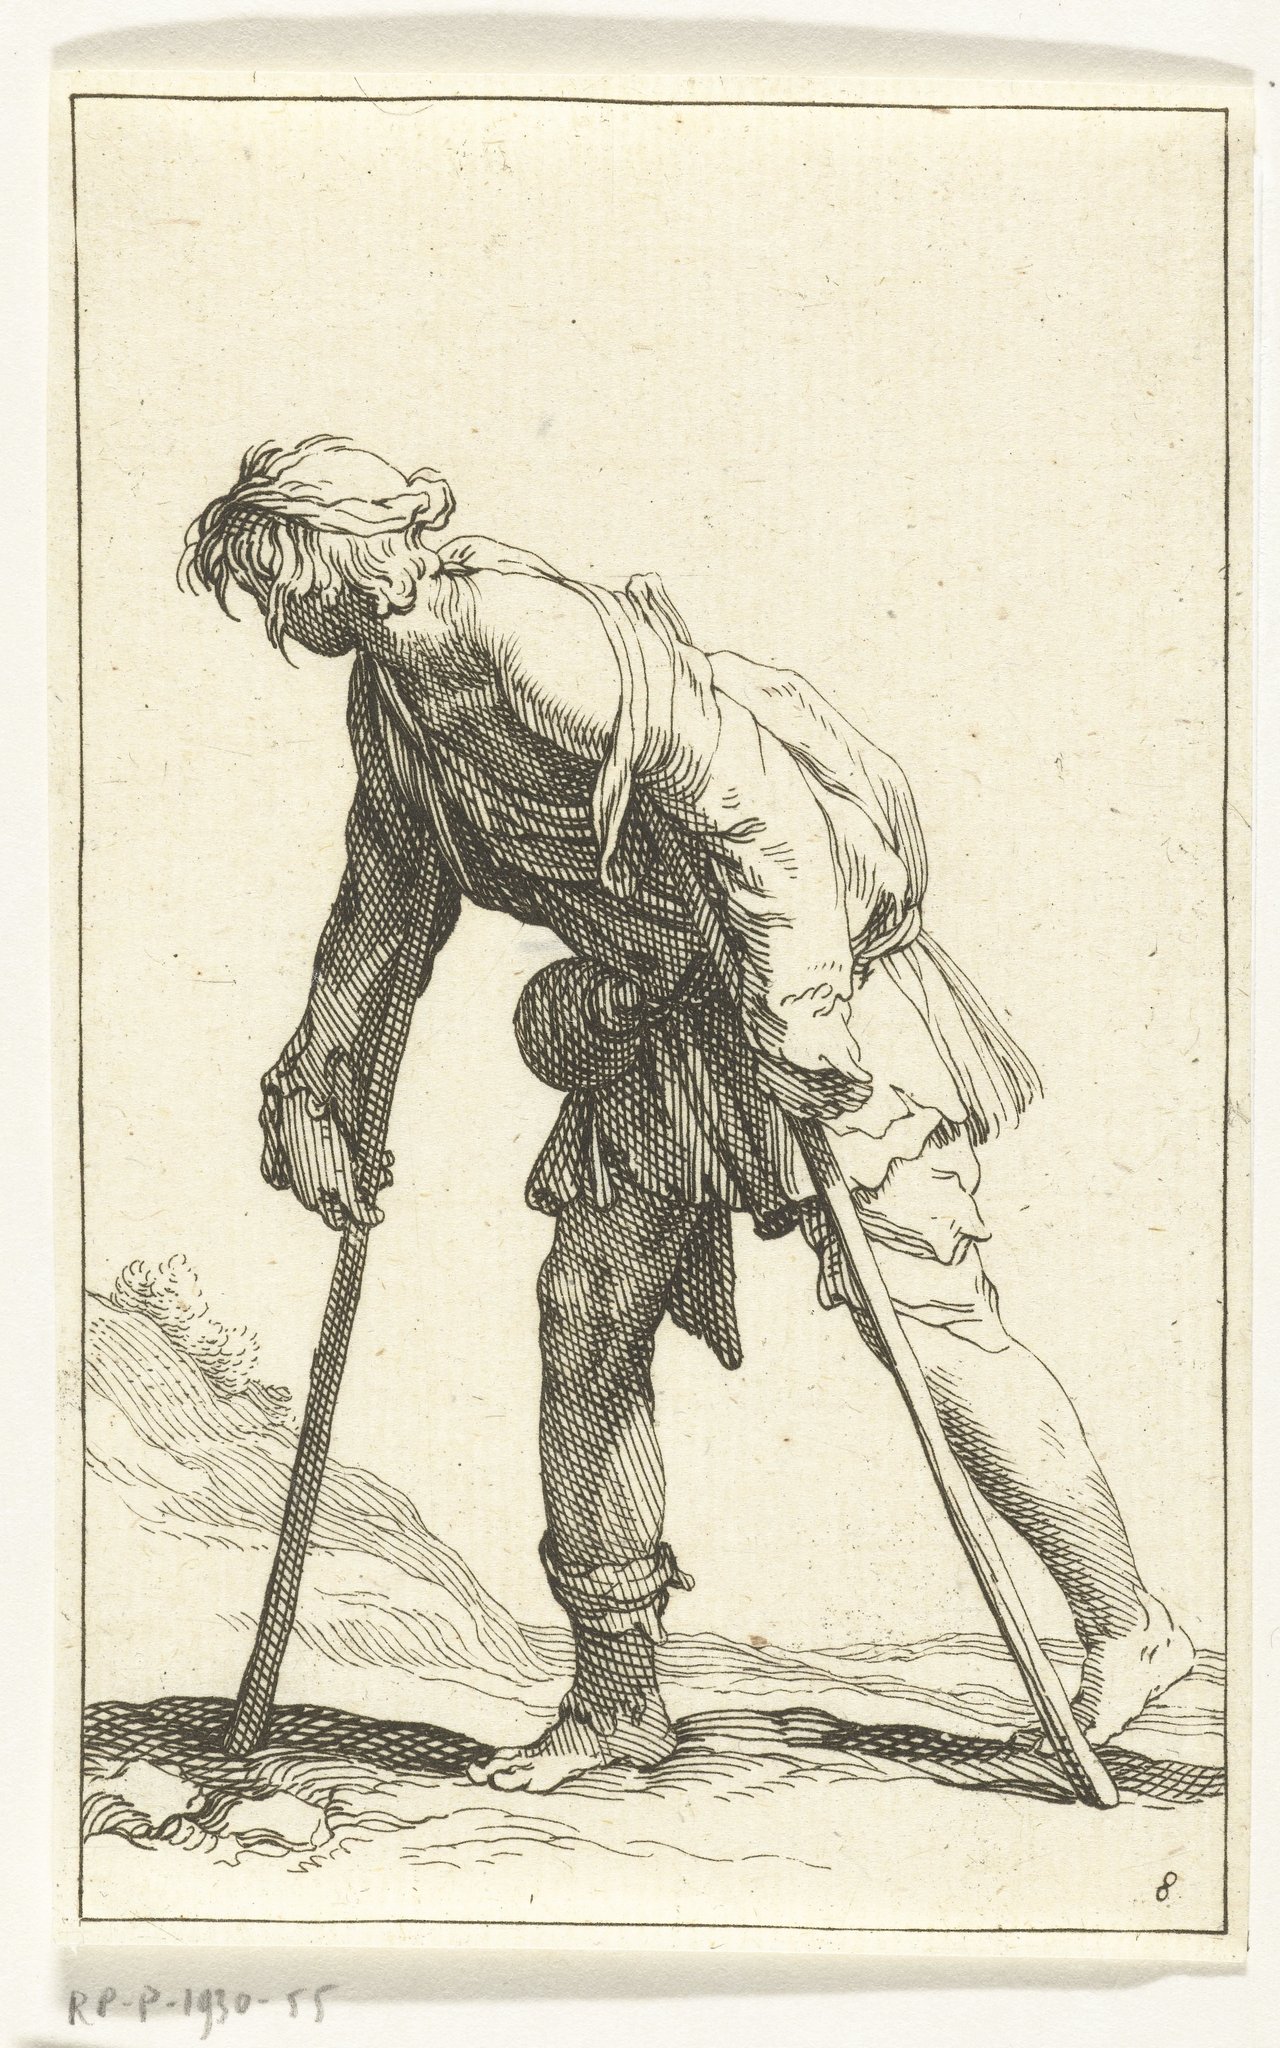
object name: print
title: Bedelaar lopend op krukken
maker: frederick bloemaert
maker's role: print maker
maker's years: 1614-1669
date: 1635-1669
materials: paper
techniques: engraving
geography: utrecht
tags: beggar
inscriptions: collector's mark: Lugt 2233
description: Een jongeman loopt voorovergebogen steunend op twee krukken.